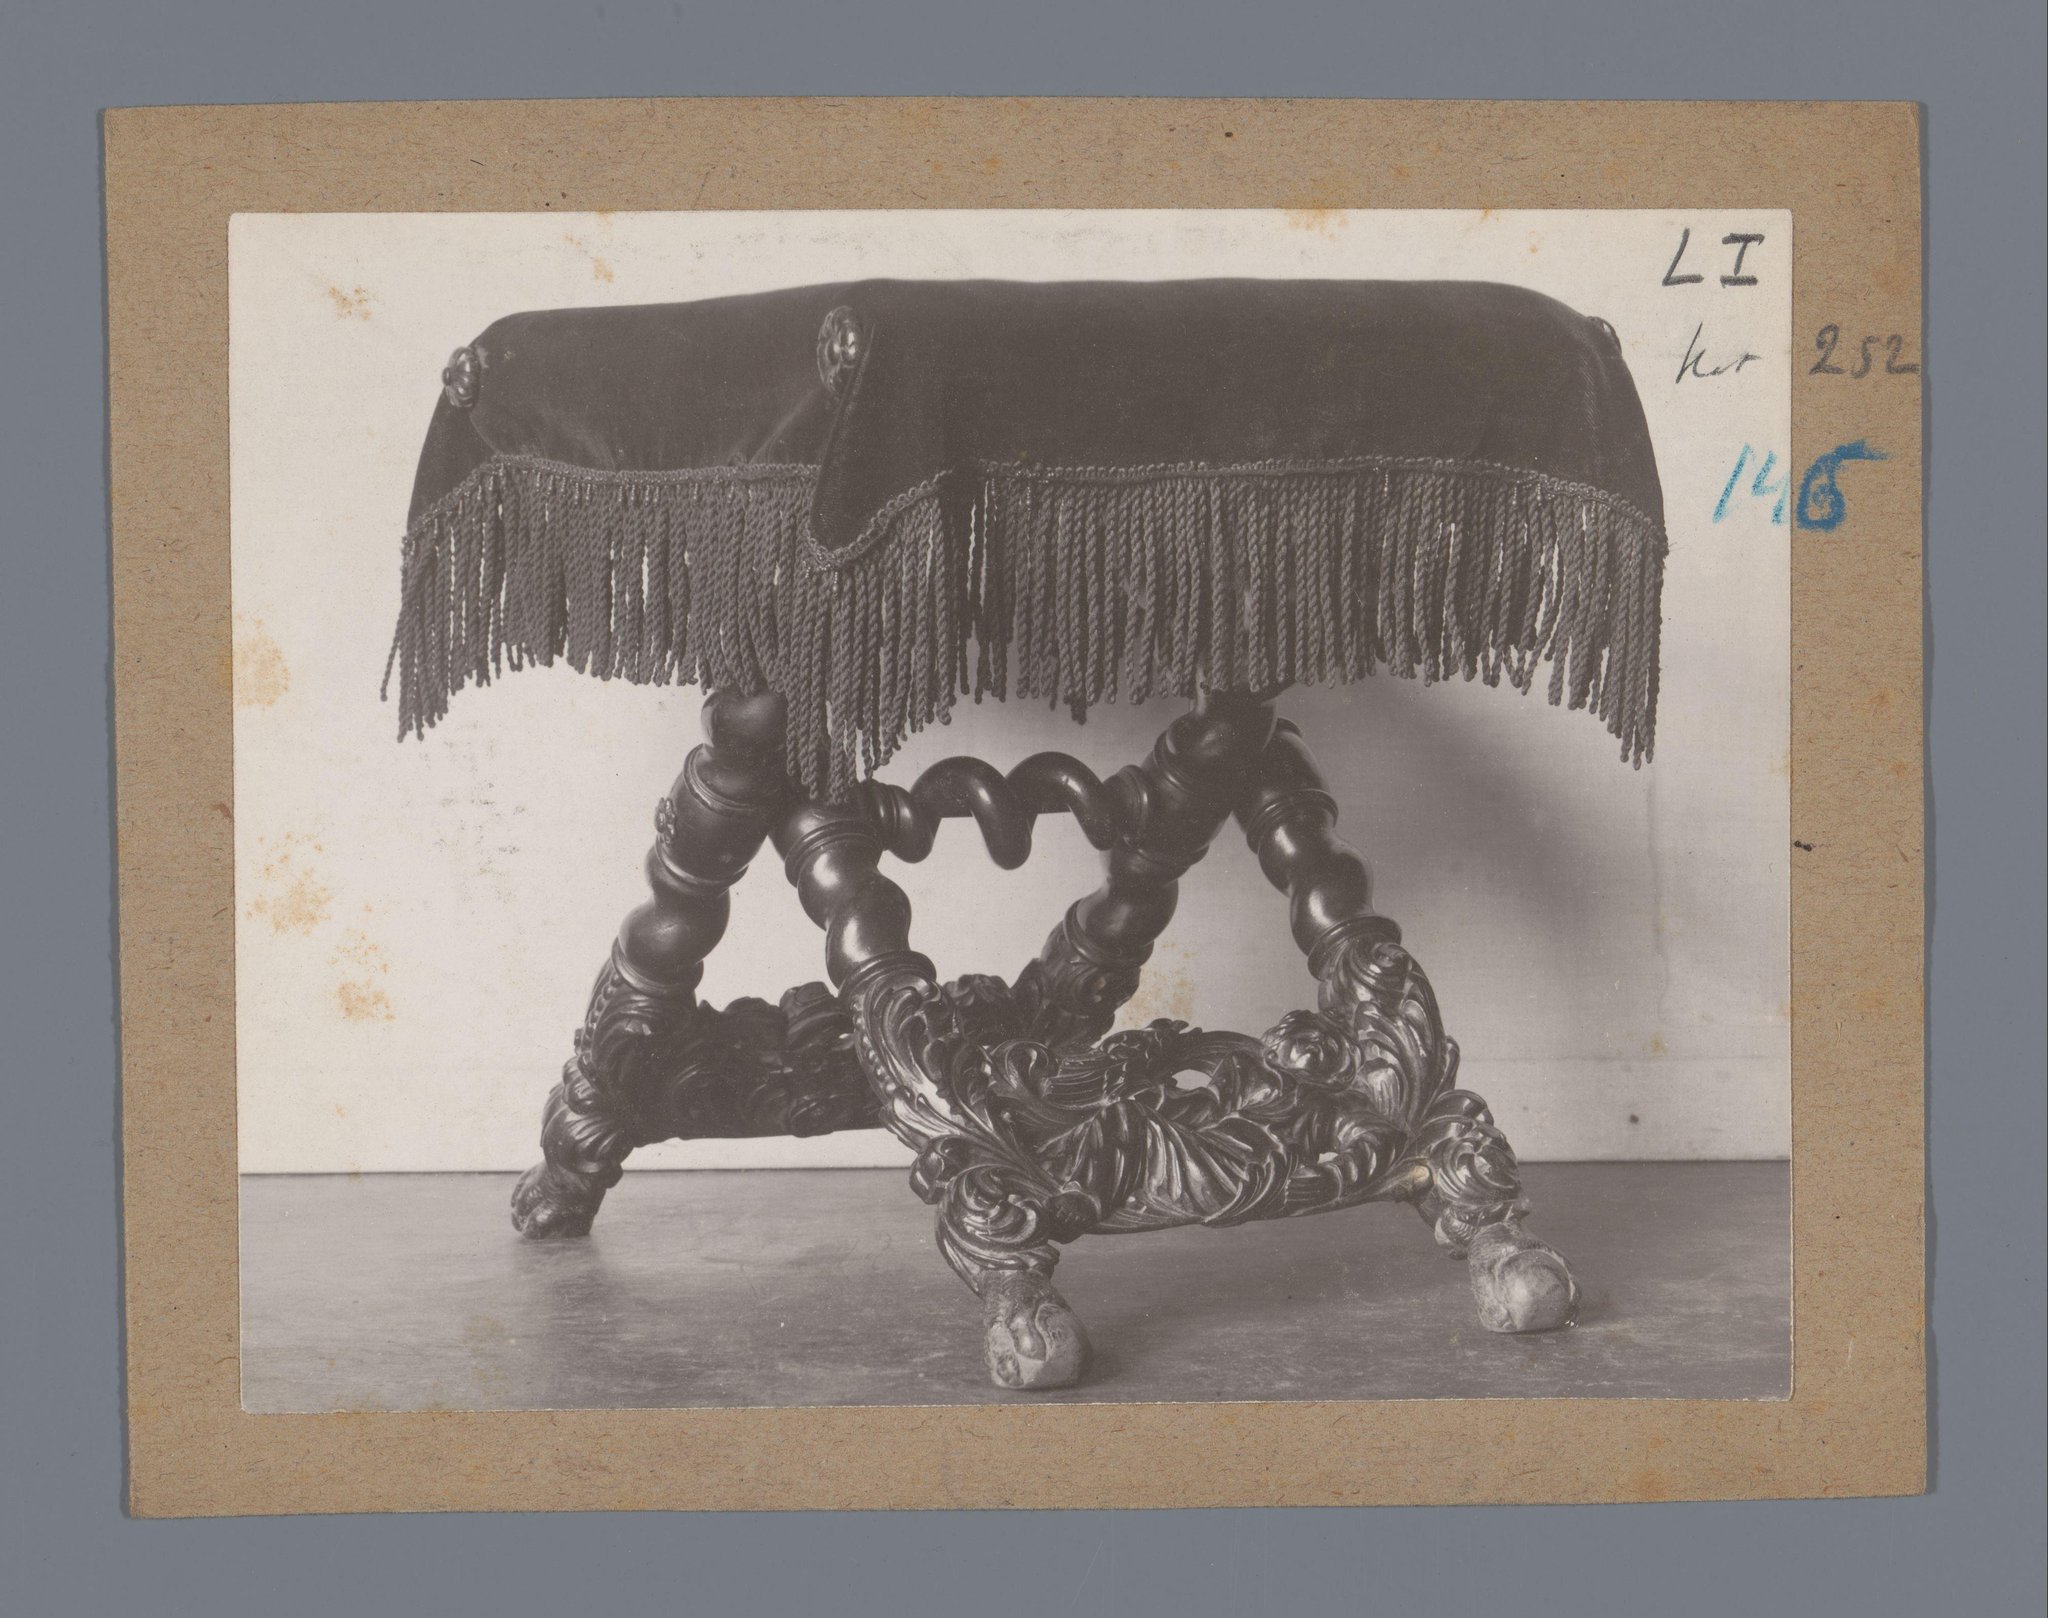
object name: photograph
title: Kruk met gedraaide poten gedecoreerd met bladmotieven en een liggende figuur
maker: Anonymous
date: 1875-1900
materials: photographic support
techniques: matte daylight collodion silver print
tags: stool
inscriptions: number: ‘LI Kat 252 145’, collector's mark: ‘Kunstnijverheidschool Quellinus Amsterdam Frans Halsstraat 14.’, collector's mark: ‘Instituut voor kunst-nijverheidsonderwijs Gabriël Metsustraat No. 16, Amsterdam’